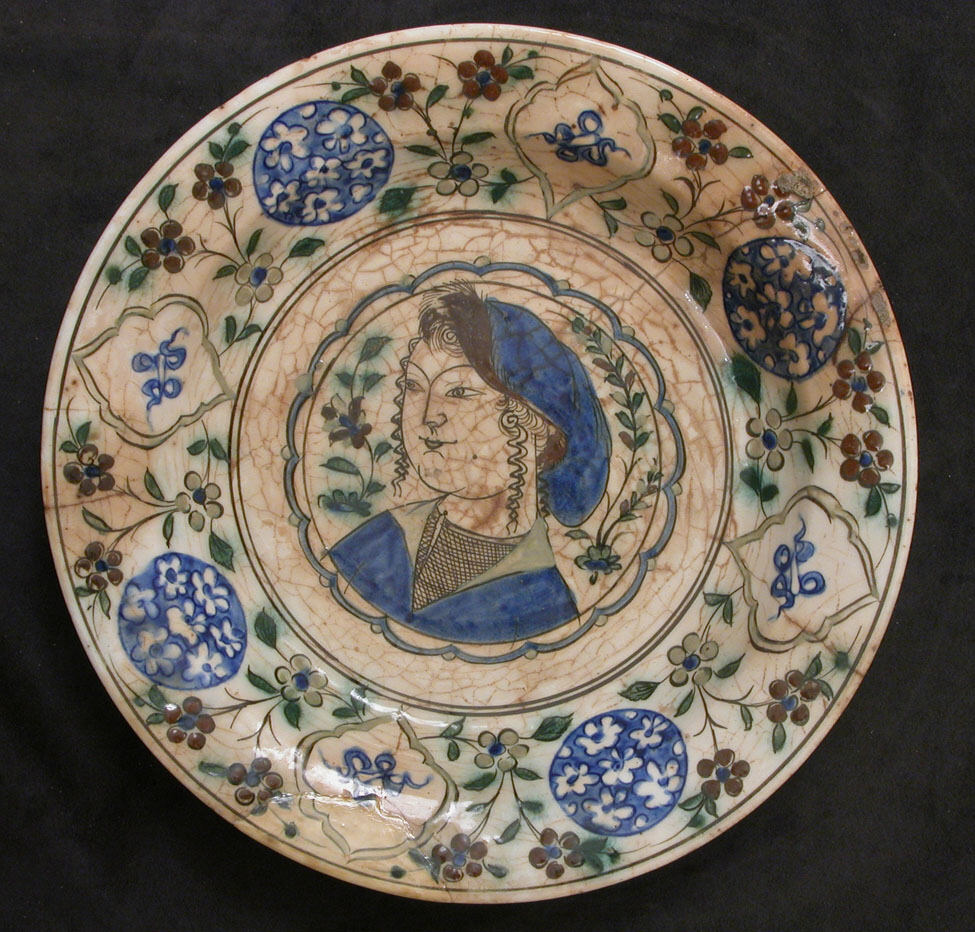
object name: dish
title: Dish Depicting a Woman Bust and Floral Decoration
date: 1601-1650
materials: glaze, stonepaste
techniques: painting, polychrome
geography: iran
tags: women